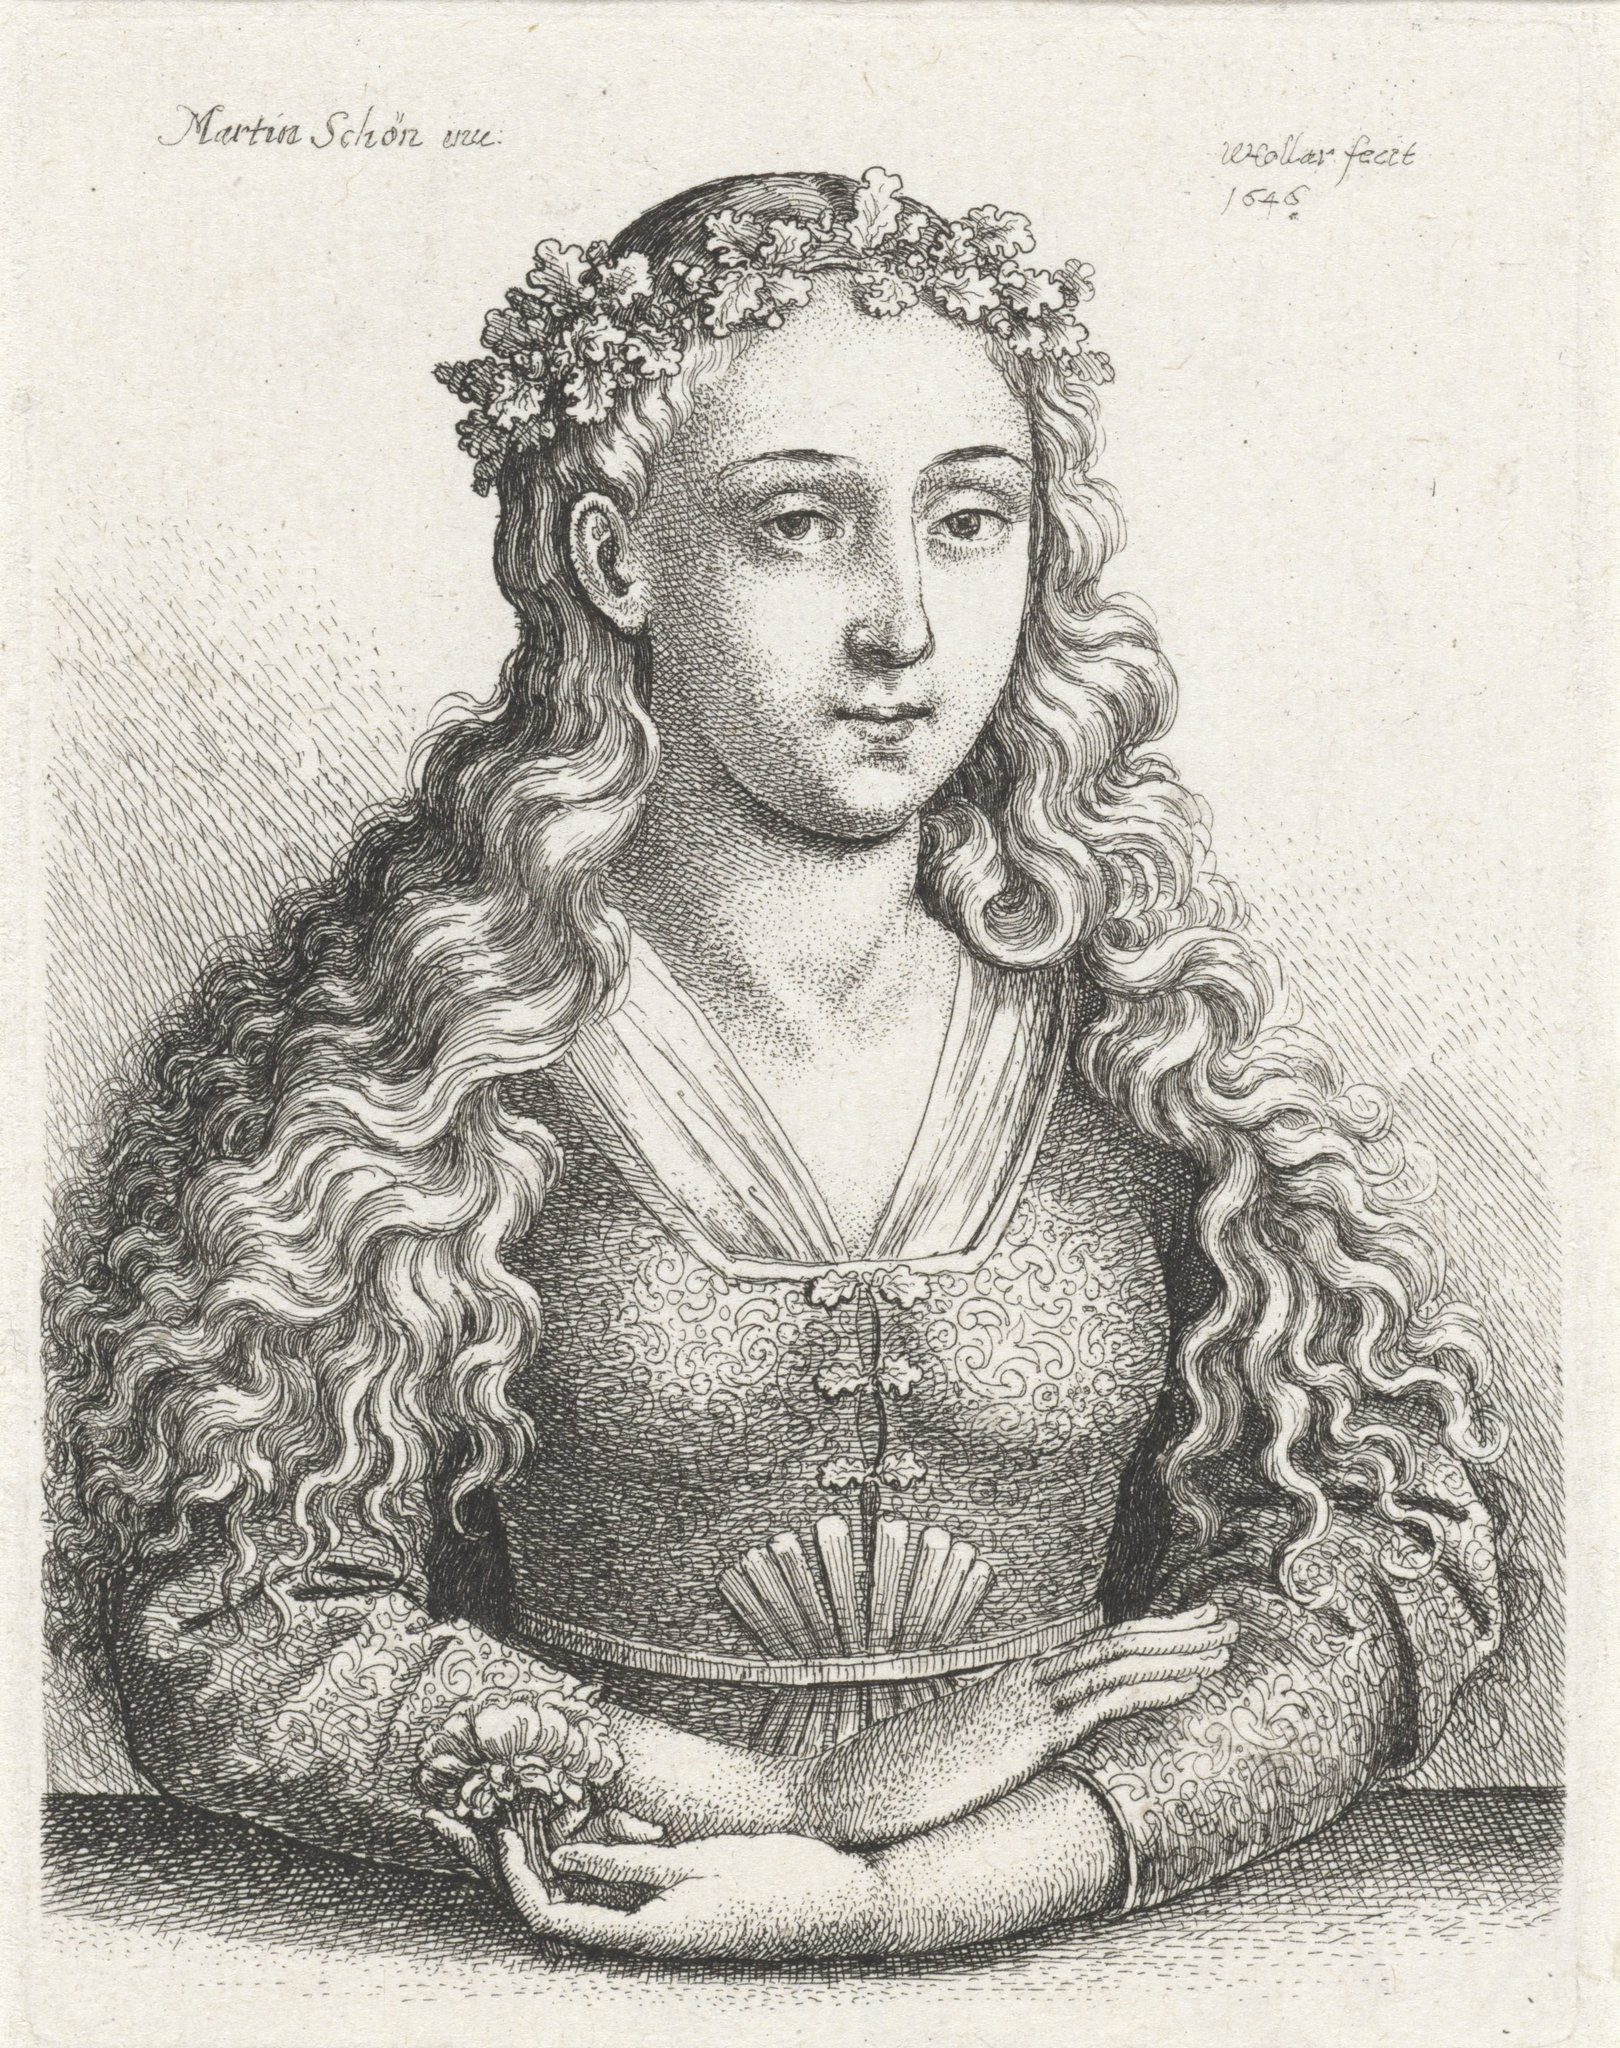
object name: print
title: Portret van vrouw met bloem en een lauwerkrans van eikenbladeren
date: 1646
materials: paper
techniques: etching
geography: antwerp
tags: anonymous historical person portrayed alone - bb - woman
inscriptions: collector's mark: Lugt 240